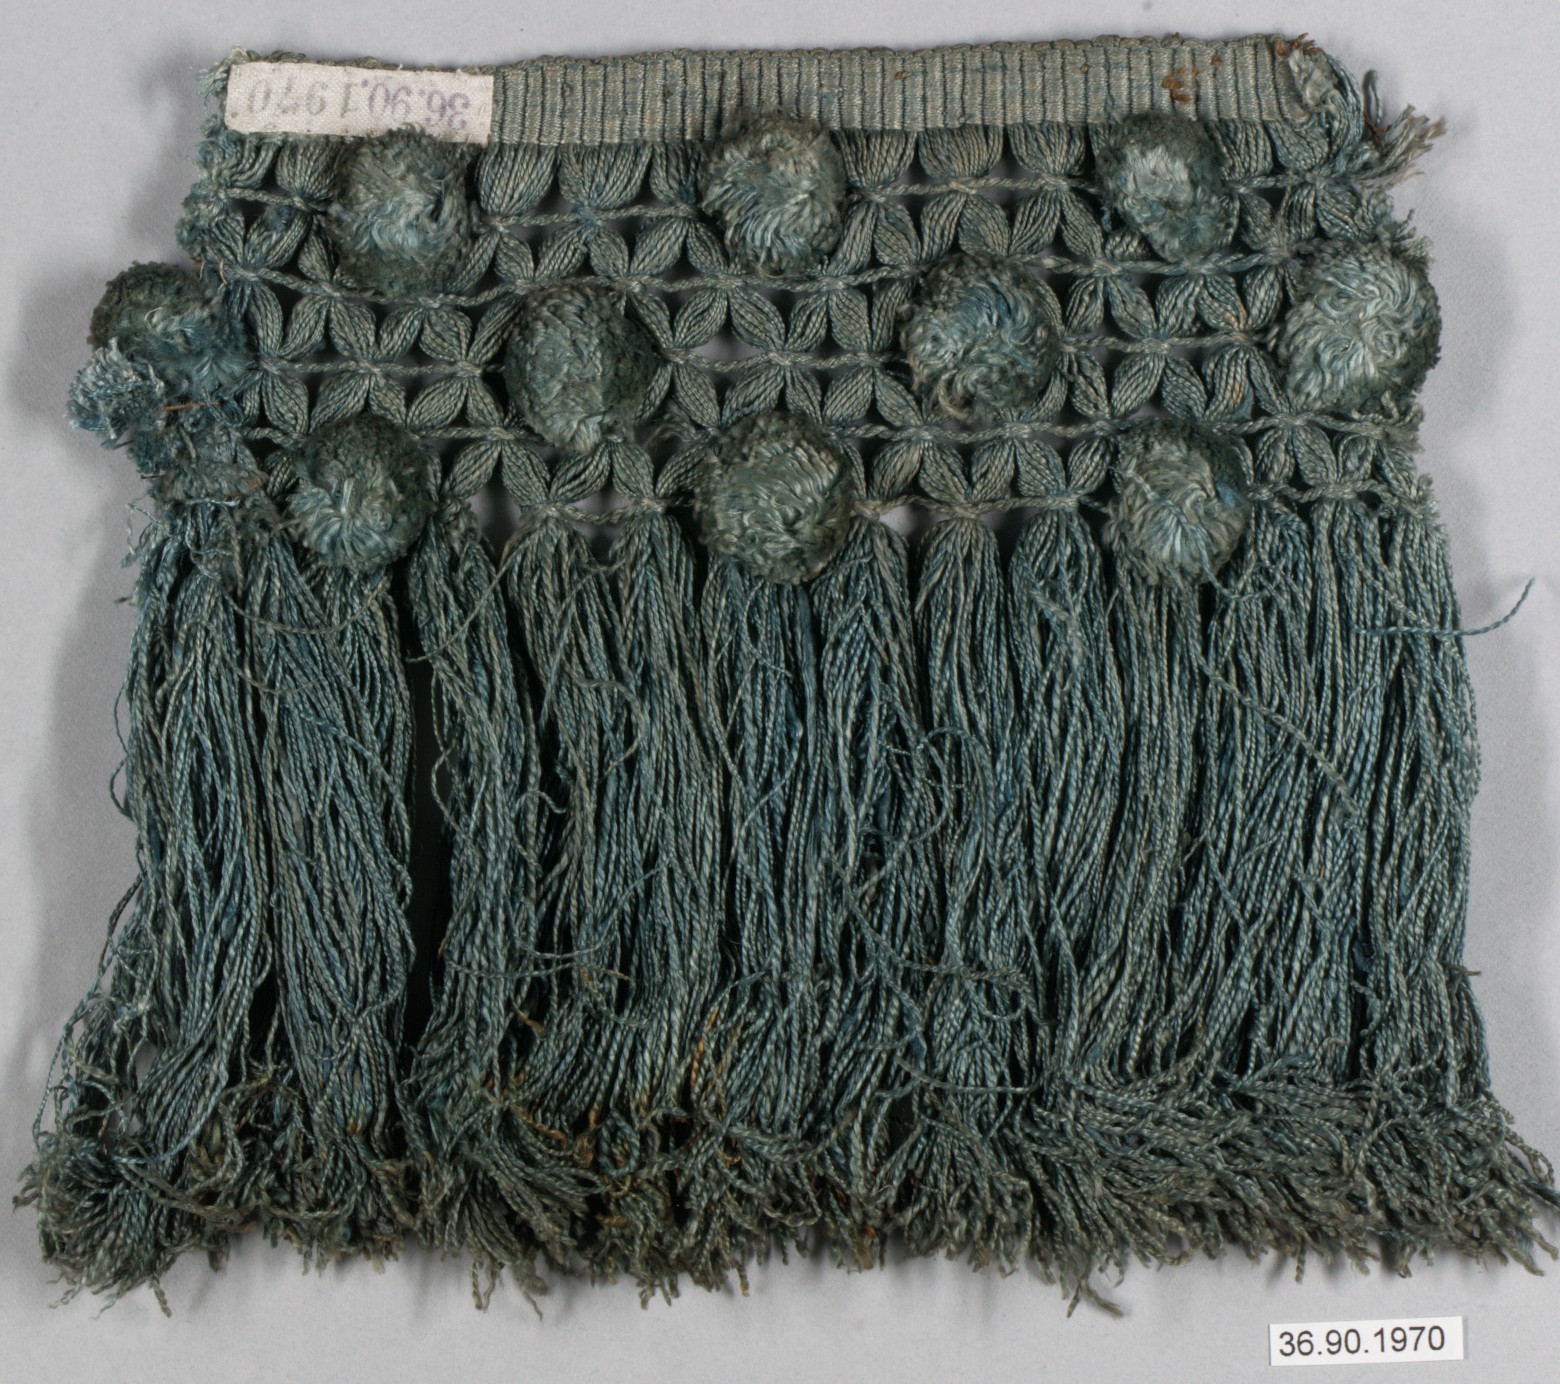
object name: fringe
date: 1801-1900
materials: silk